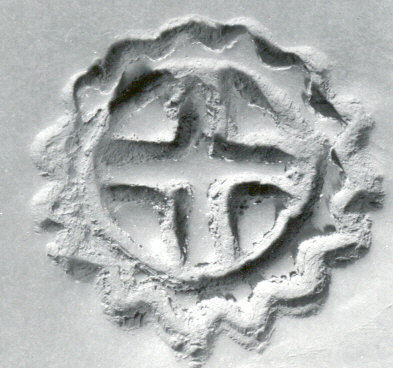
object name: stamp seal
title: Compartmented stamp seal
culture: bactria-margiana archaeological complex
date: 2333-1668 BCE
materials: copper alloy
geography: bactria-margiana